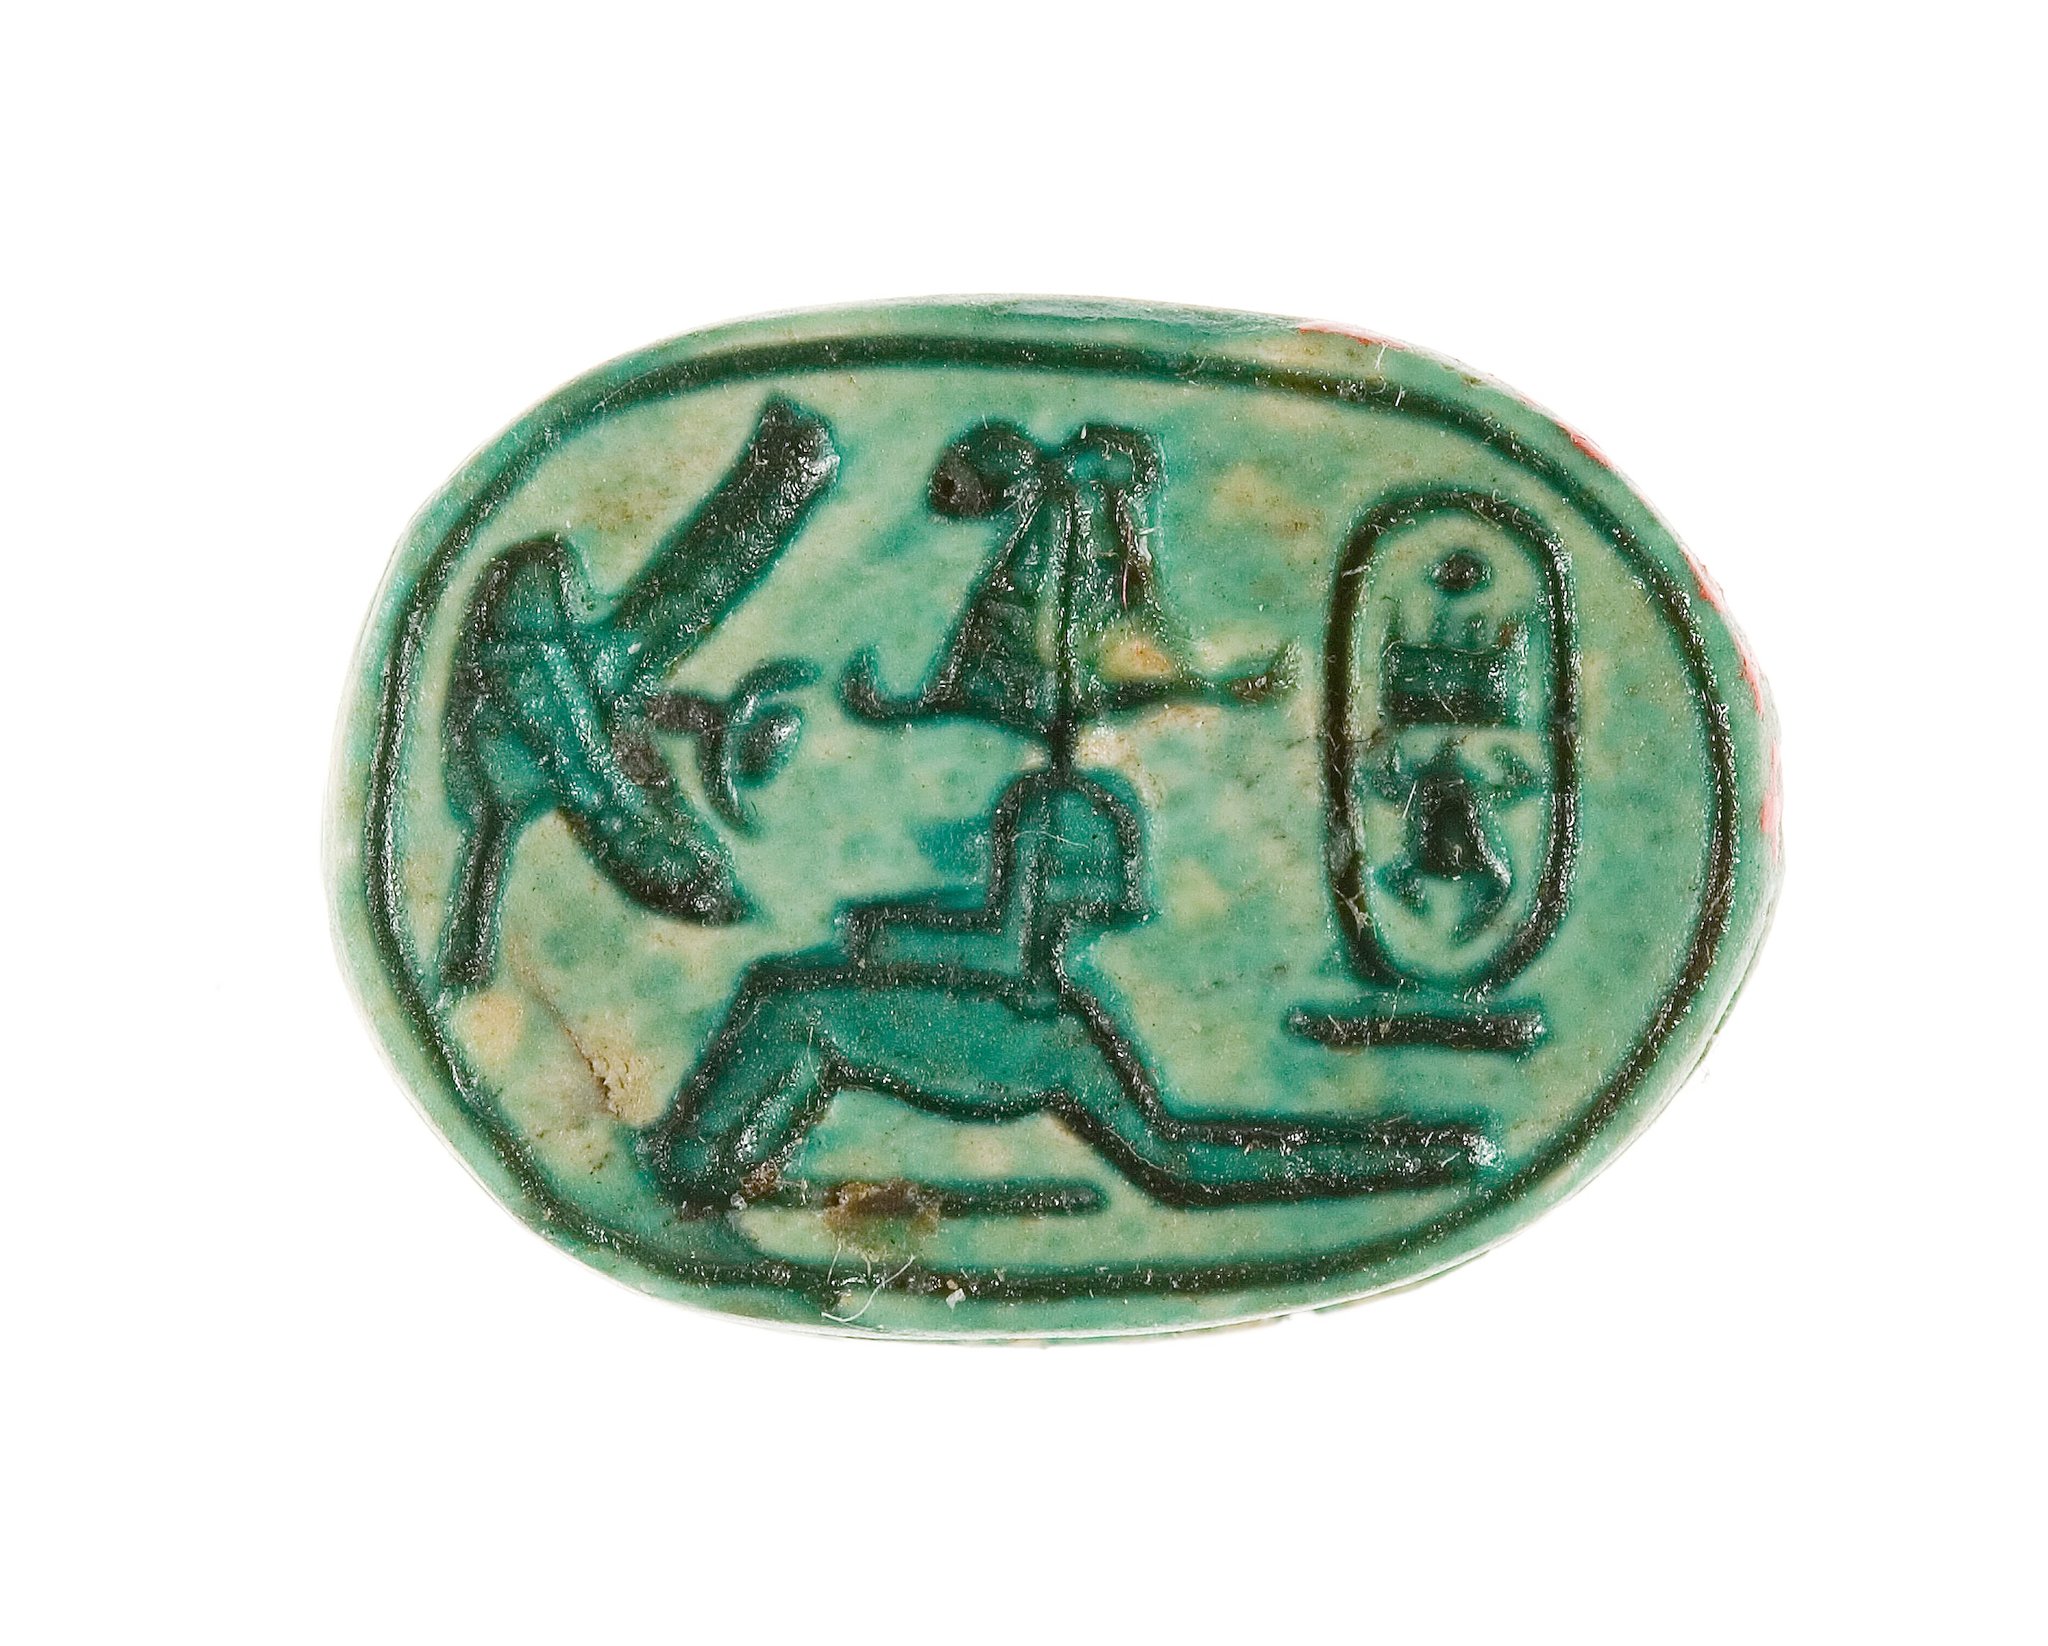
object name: scarab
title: Scarab Inscribed with the Throne Name of Thutmose III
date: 1479-1458 BCE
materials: stone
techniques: glazing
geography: egypt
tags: hieroglyphs,scarabs